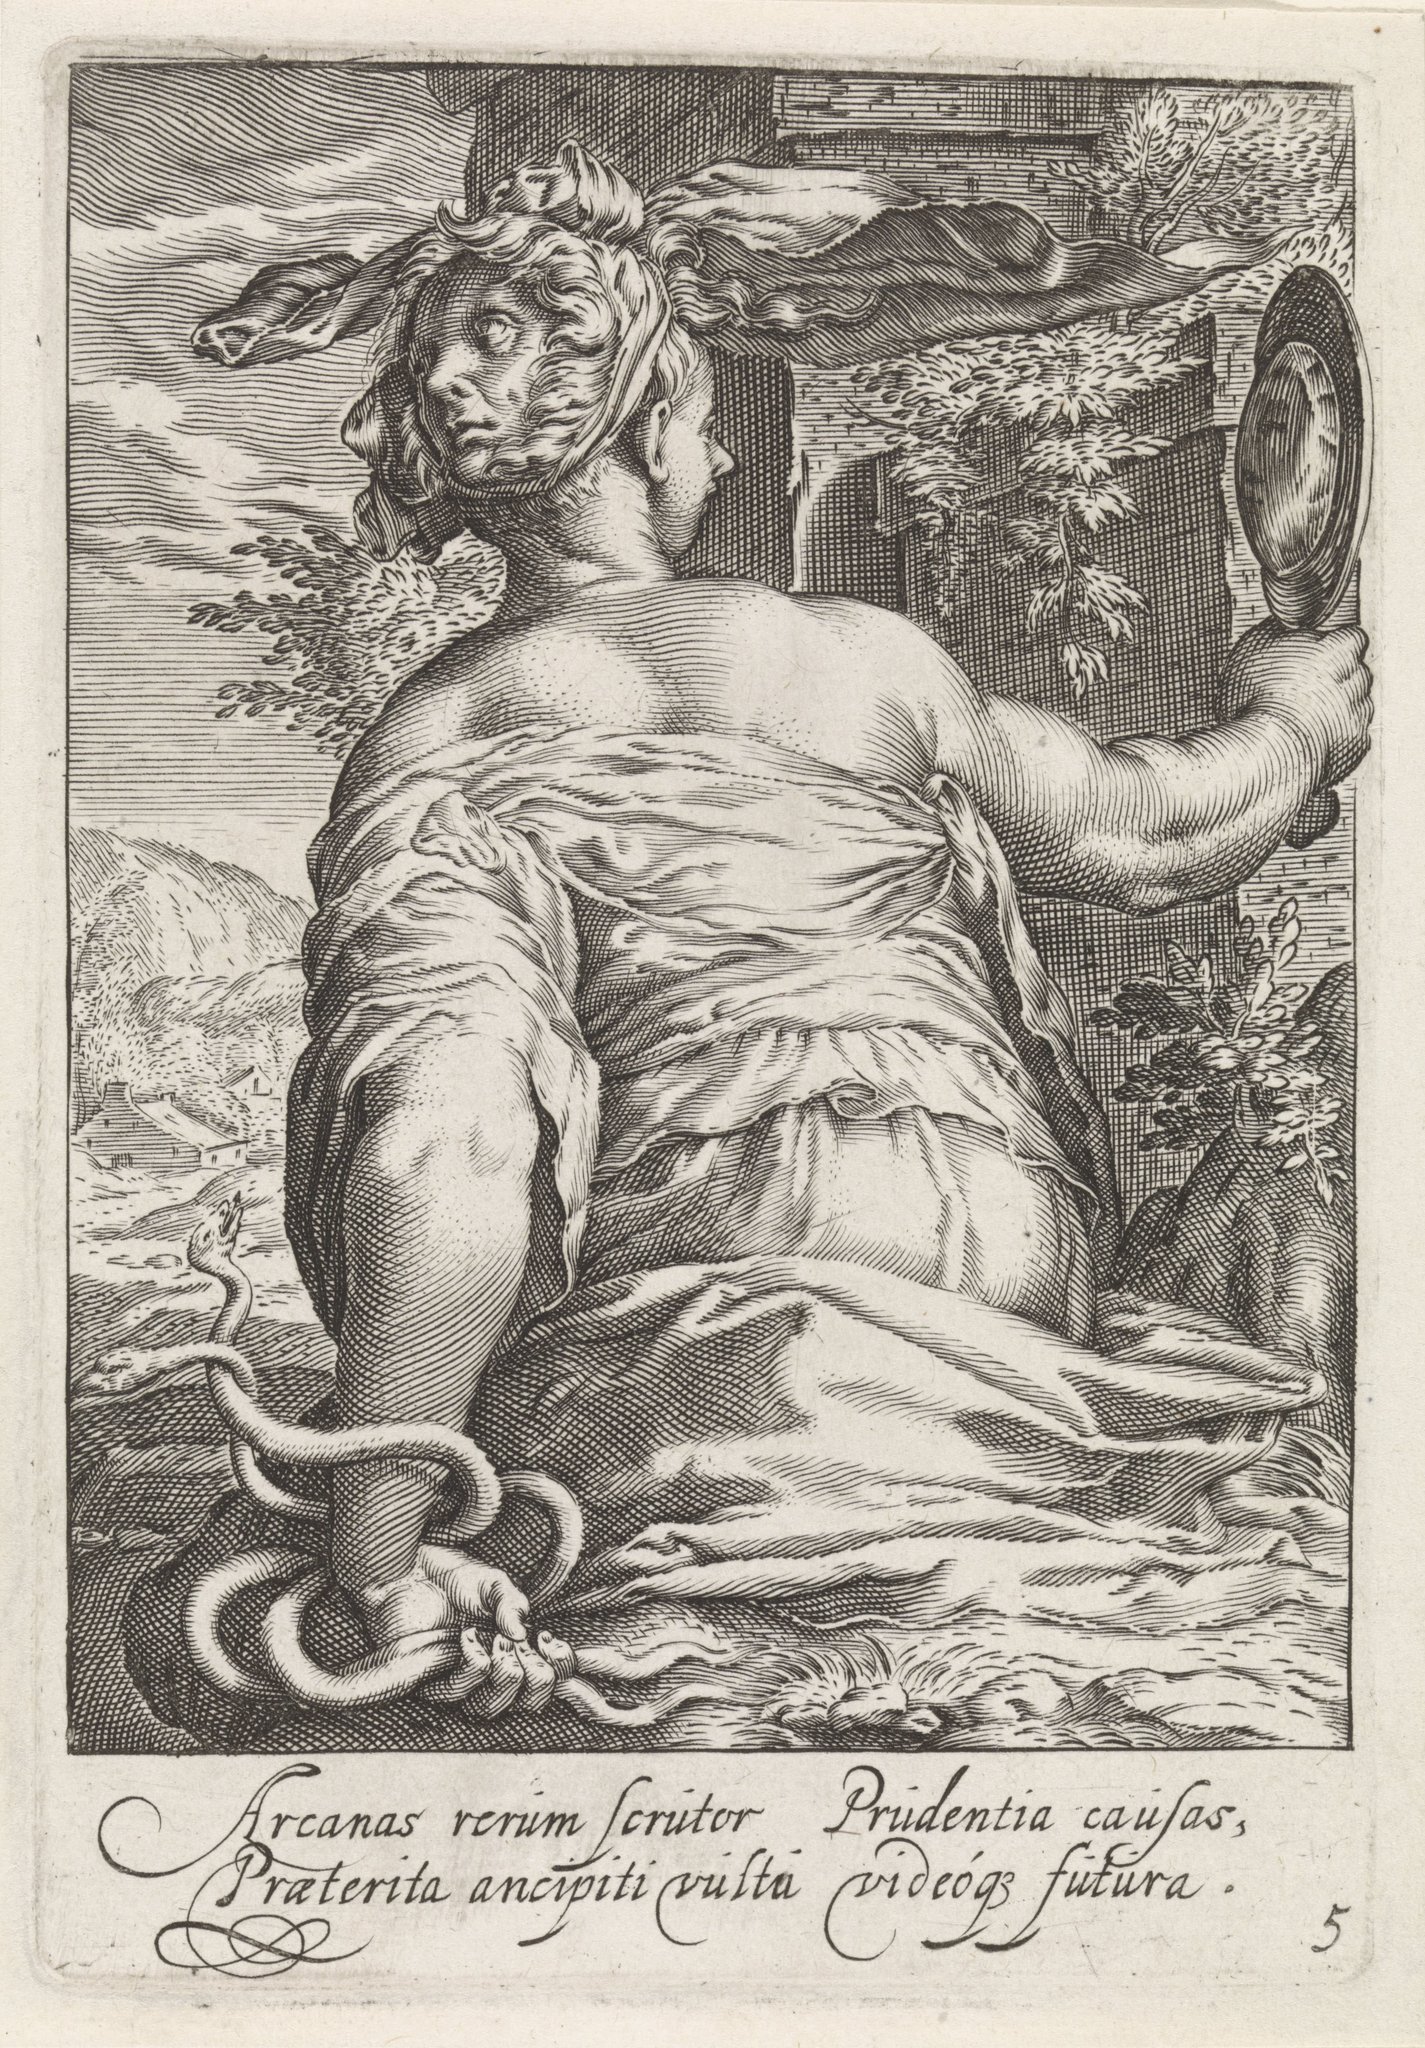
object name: print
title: Voorzichtigheid (Prudentia)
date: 1601-1652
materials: paper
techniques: engraving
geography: amsterdam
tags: prudence, 'prudentia'; 'prudenza' (ripa) ~ one of the four cardinal virtues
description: Een vrouwenfiguur met een tweede gezicht op haar achterhoofd als personificatie van voorzichtheid (prudentia). In haar ene hand heeft zij een spiegel en in haar andere hand twee slangen.